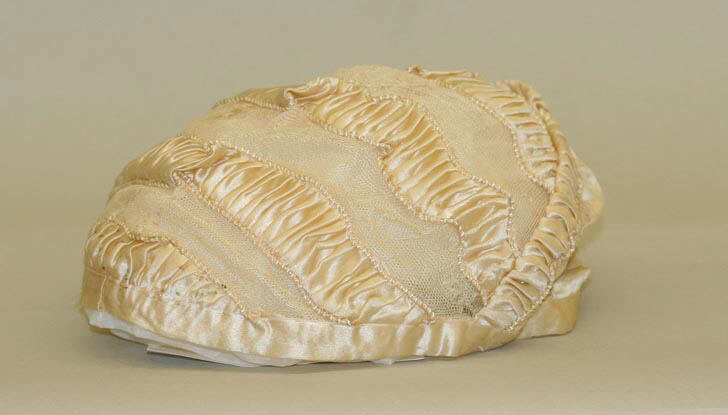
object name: cap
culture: american or european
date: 1800-1805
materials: cotton, silk